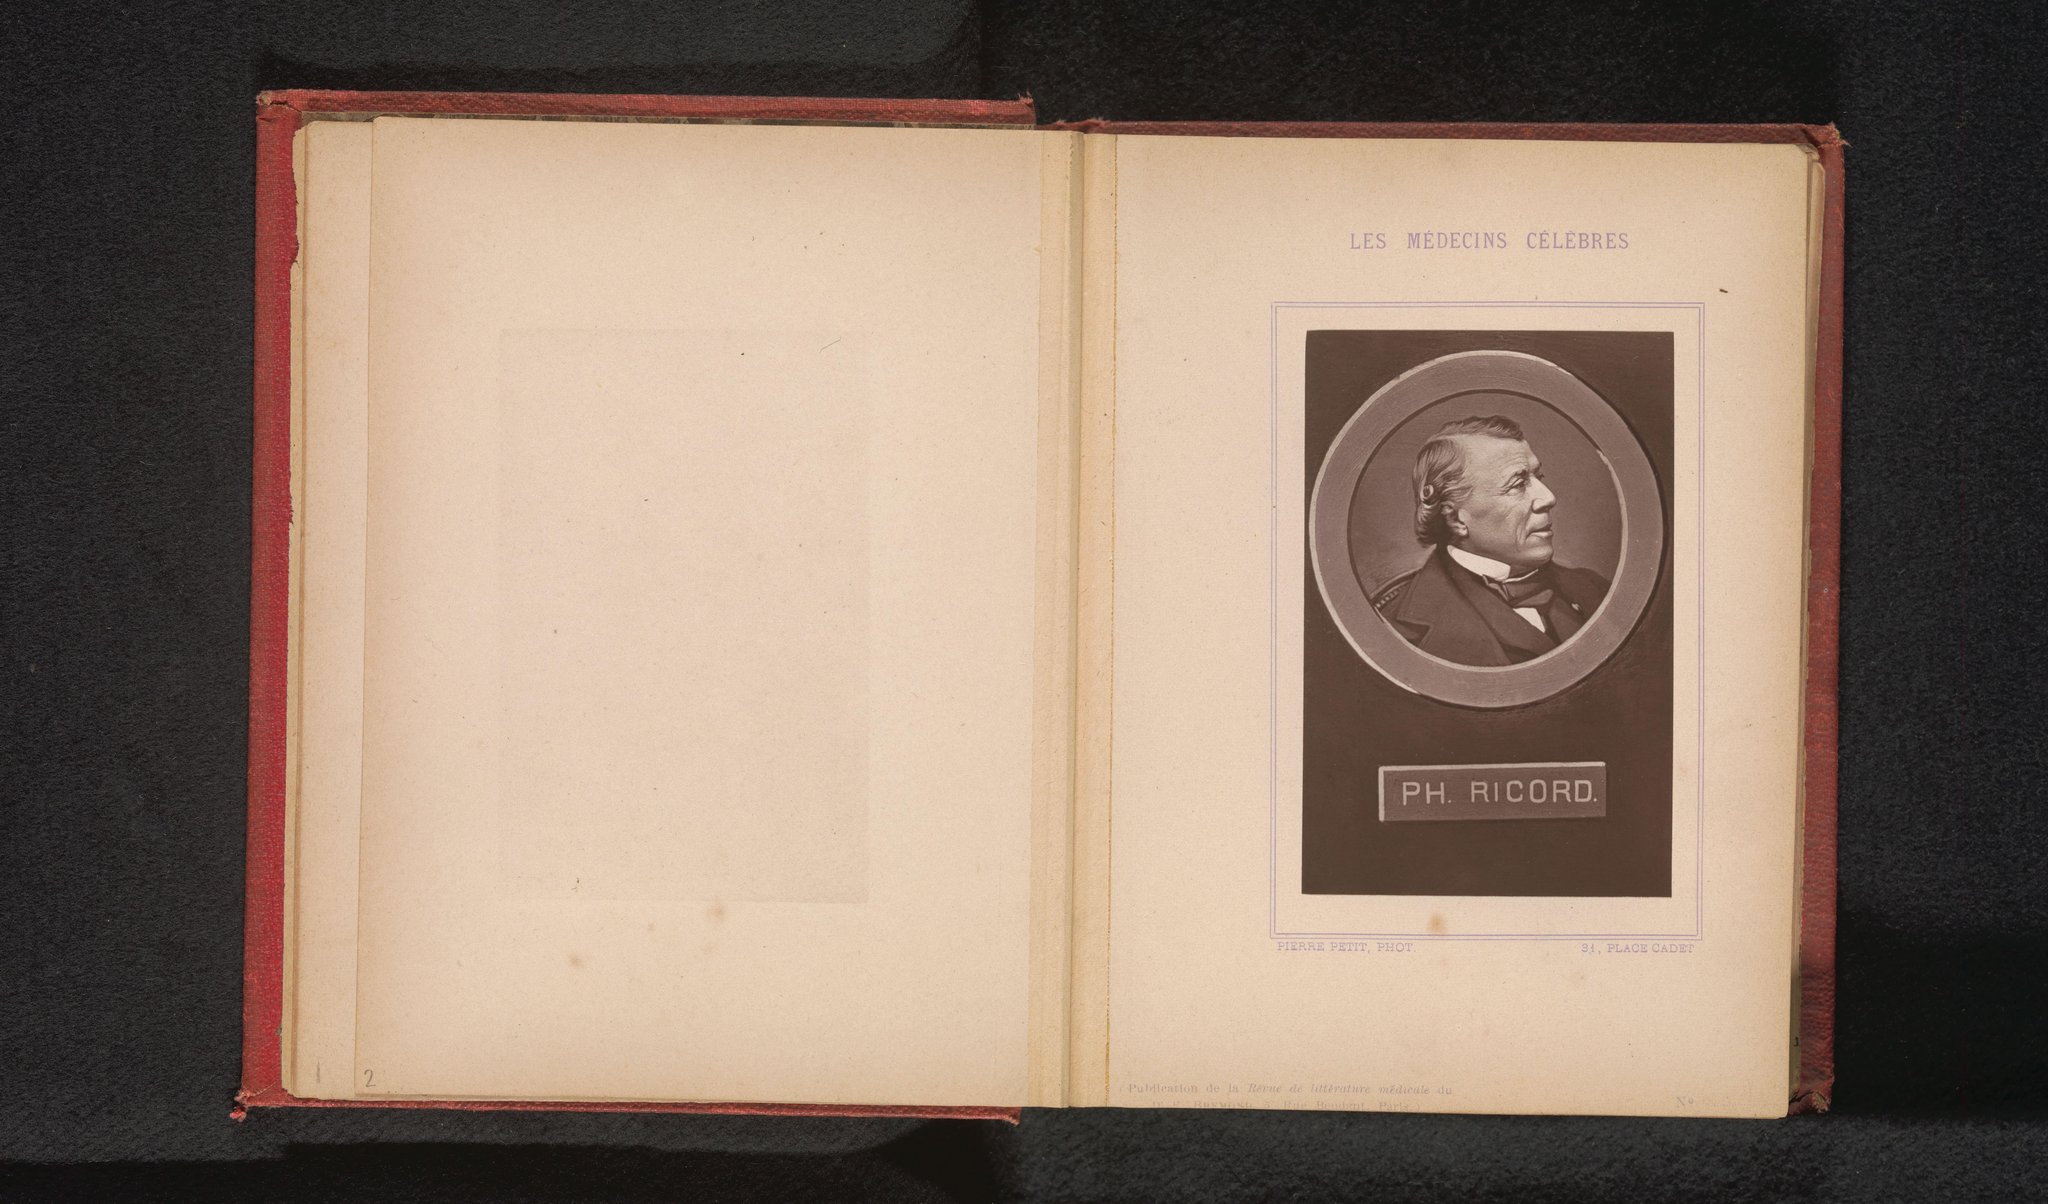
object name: photomechanical print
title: Portret van Philippe Ricord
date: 1871-1879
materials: paper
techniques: woodburytype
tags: adult man, historical persons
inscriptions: inscription: ‘(Publication de la Revue de litterature médicale du/ ...]’